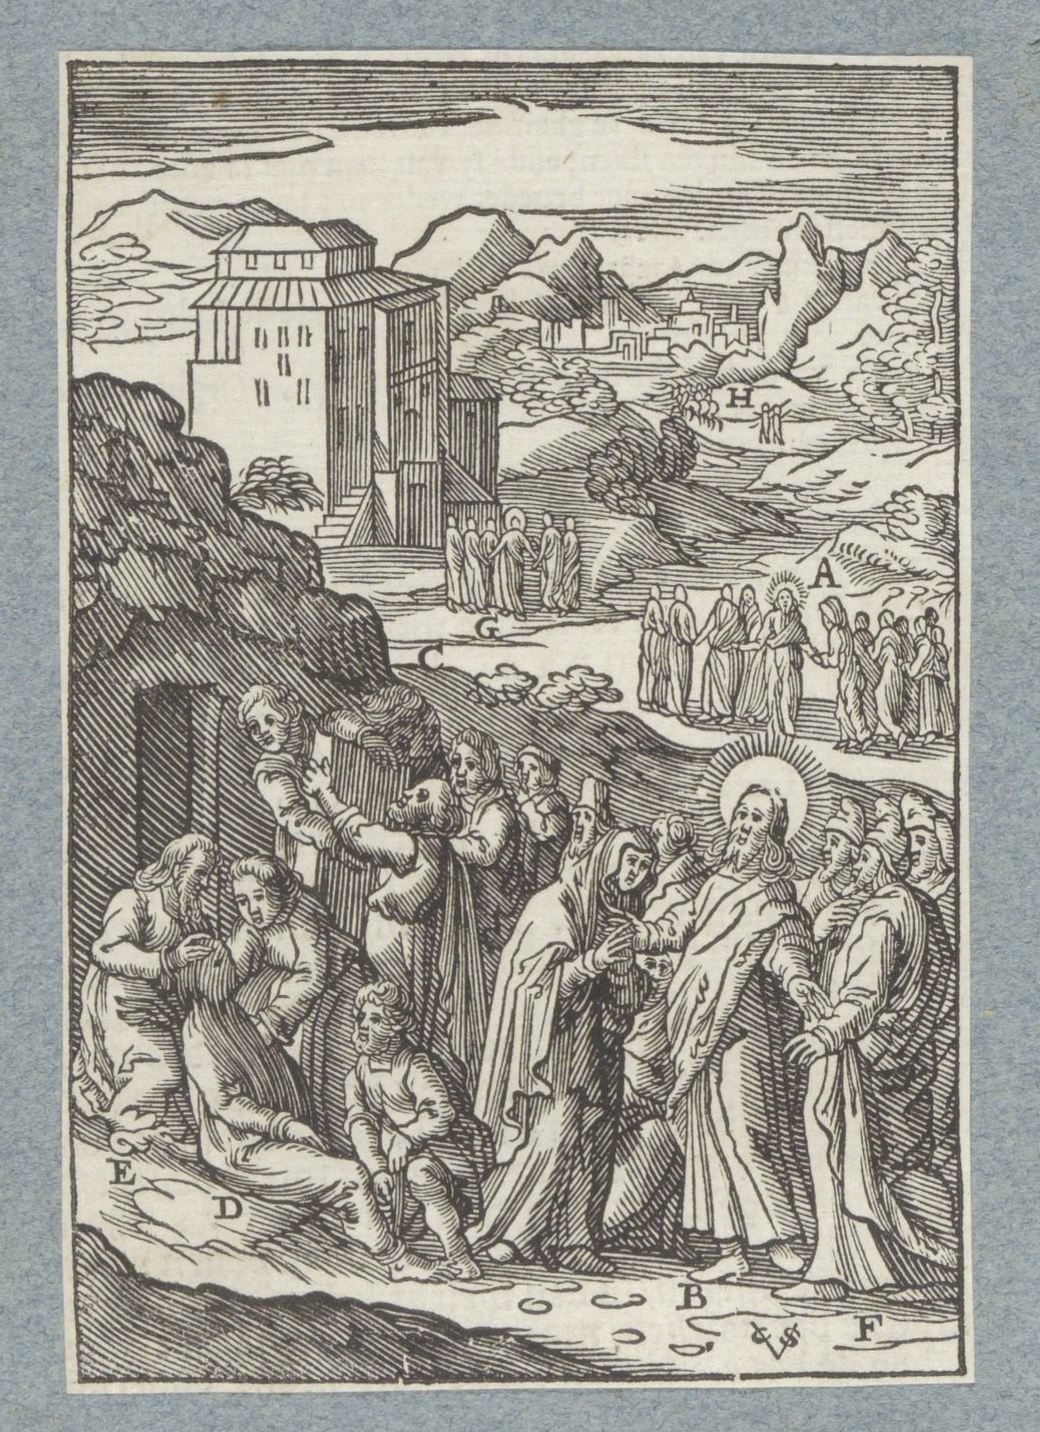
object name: book illustration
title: Opwekking van Lazarus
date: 1629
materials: paper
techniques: letterpress printing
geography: antwerp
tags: lazarus' shroud is removed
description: Christus staat te midden van een groep mensen bij het graf van Lazarus. Hij draagt hen op de steen voor de opening van de spelonk weg te halen. De omstanders halen de doeken waar het lichaam van Lazarus ingewikkeld is los. Bij verschillende elementen uit de voorstelling staan letters. Bij A de scène voorafgaand aan de opwekking van Lazarus: de huilende Marta voor Christus. De prent maakt deel uit van een album.